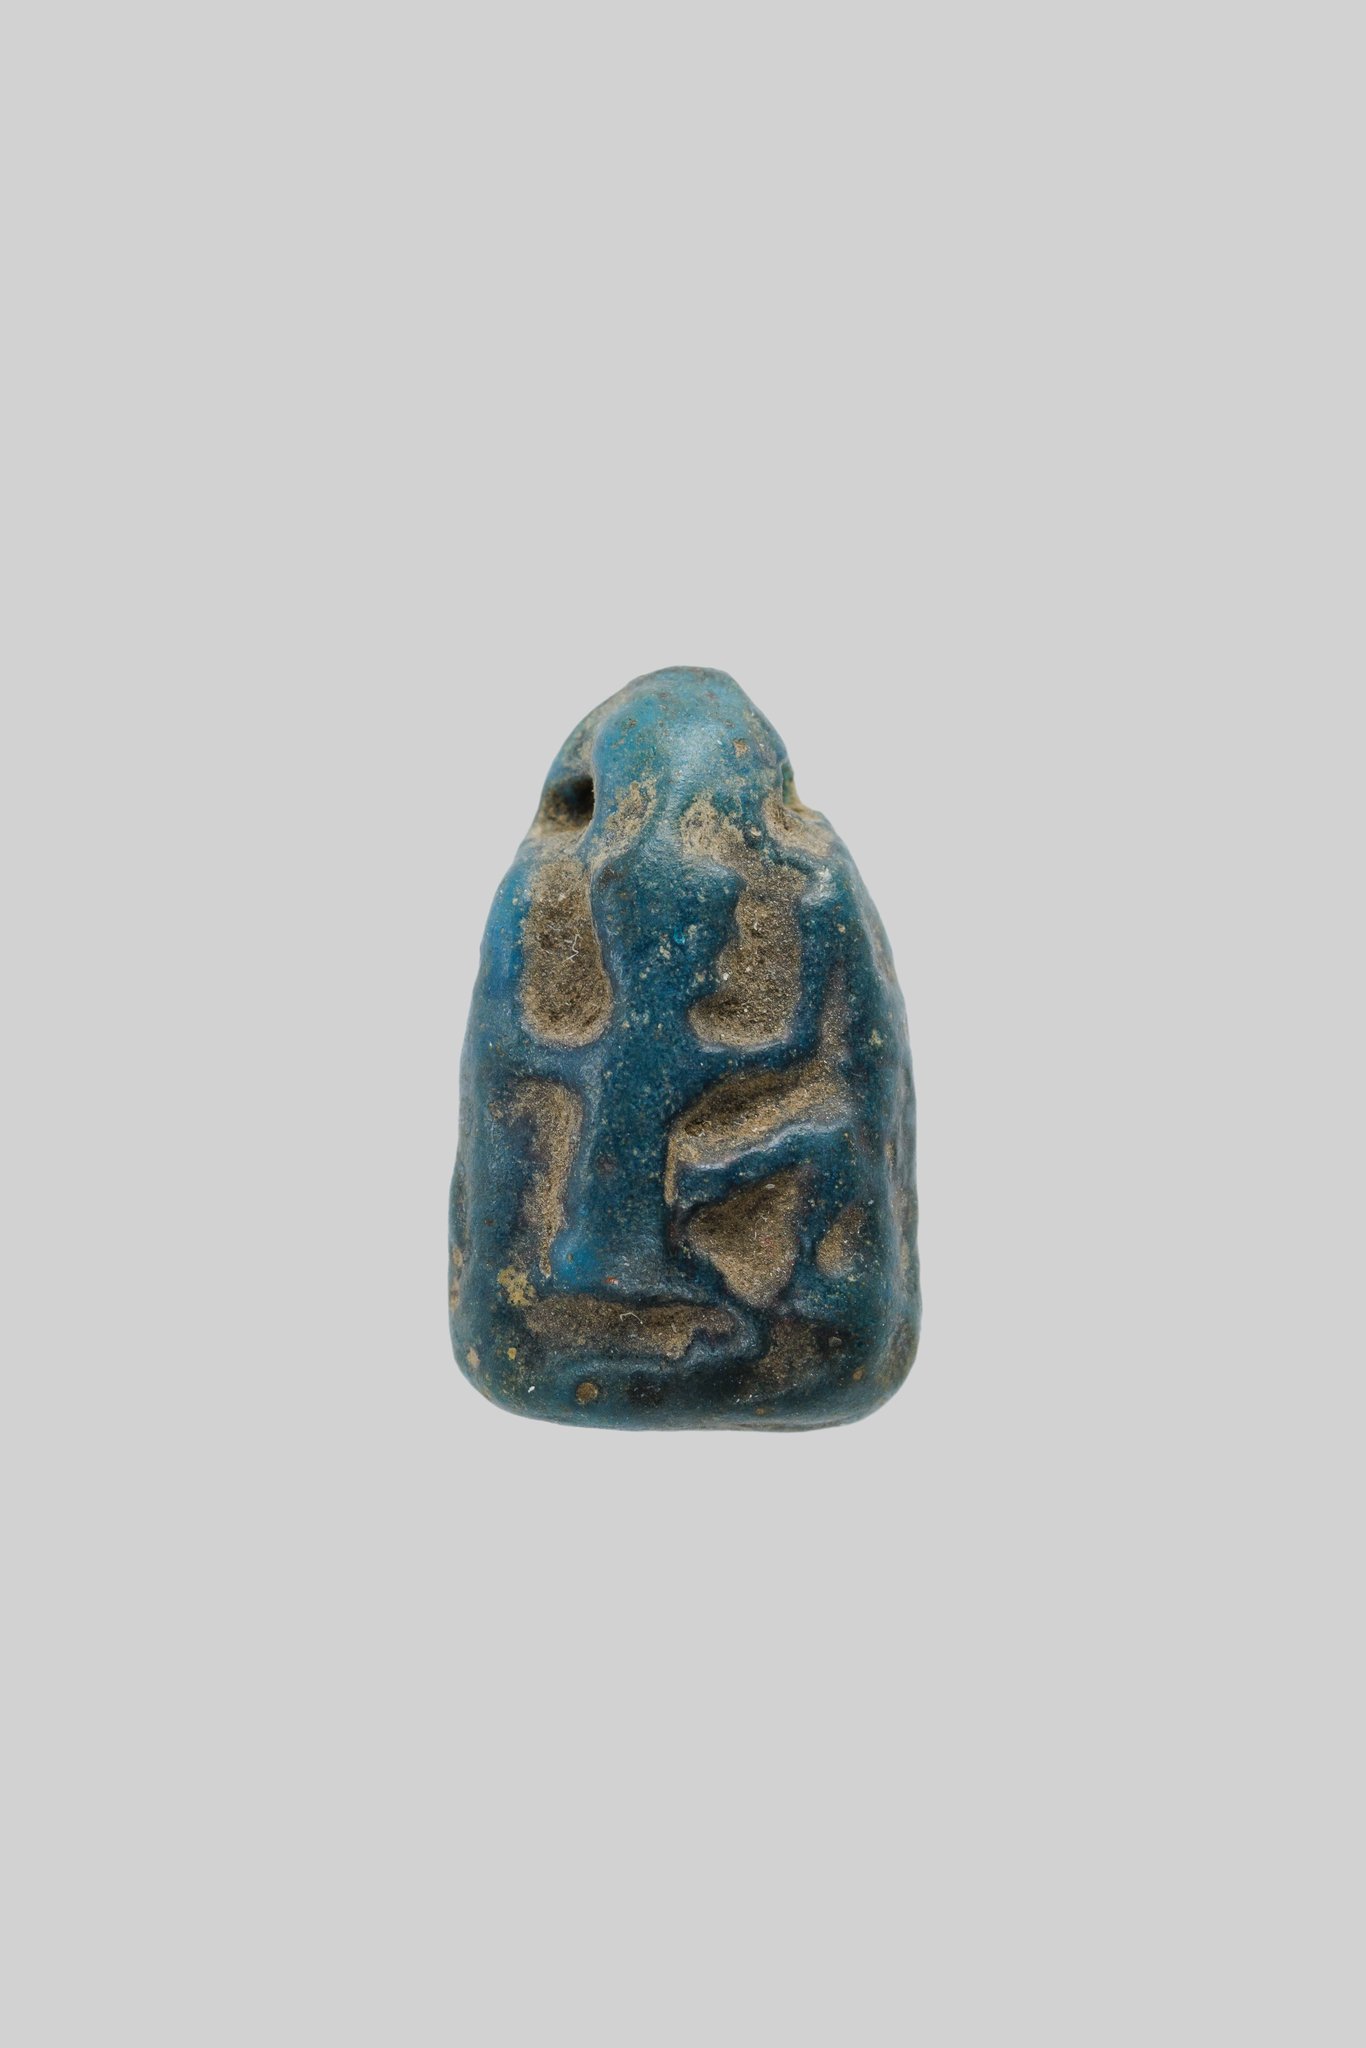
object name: amulet, shu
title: Shu amulet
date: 1295-1070 BCE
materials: faience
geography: egypt